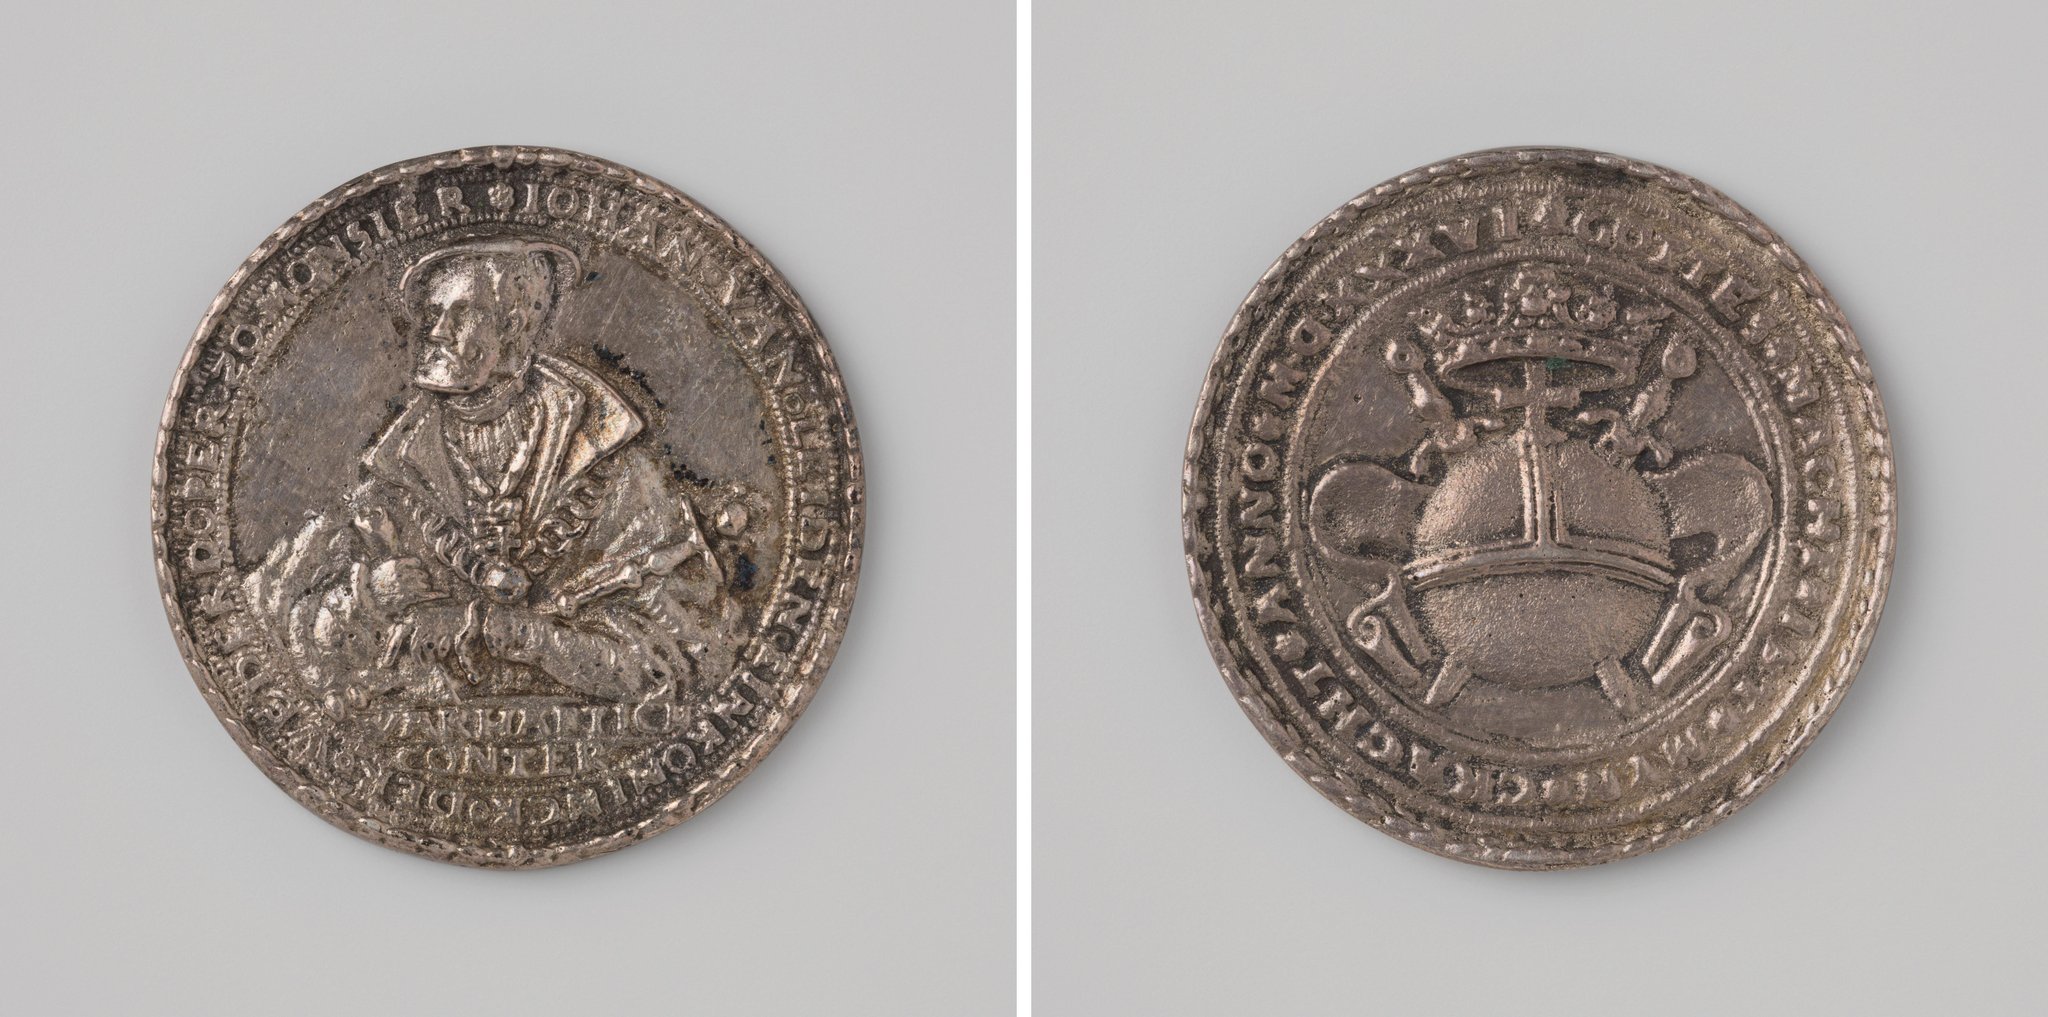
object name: history medal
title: Jan van Leiden, aanvoerder der wederdopers en de overgave van Munster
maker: Anonymous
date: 1536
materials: silver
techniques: casting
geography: munster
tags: leiden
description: Zilveren penning. Voorzijde: borststuk man met scepter en rijksappel boven opschrift, binnen omschrift en bladerkrans. Keerzijde: gekroonde rijksappel met twee dolken binnen omschrift en bladerkrans